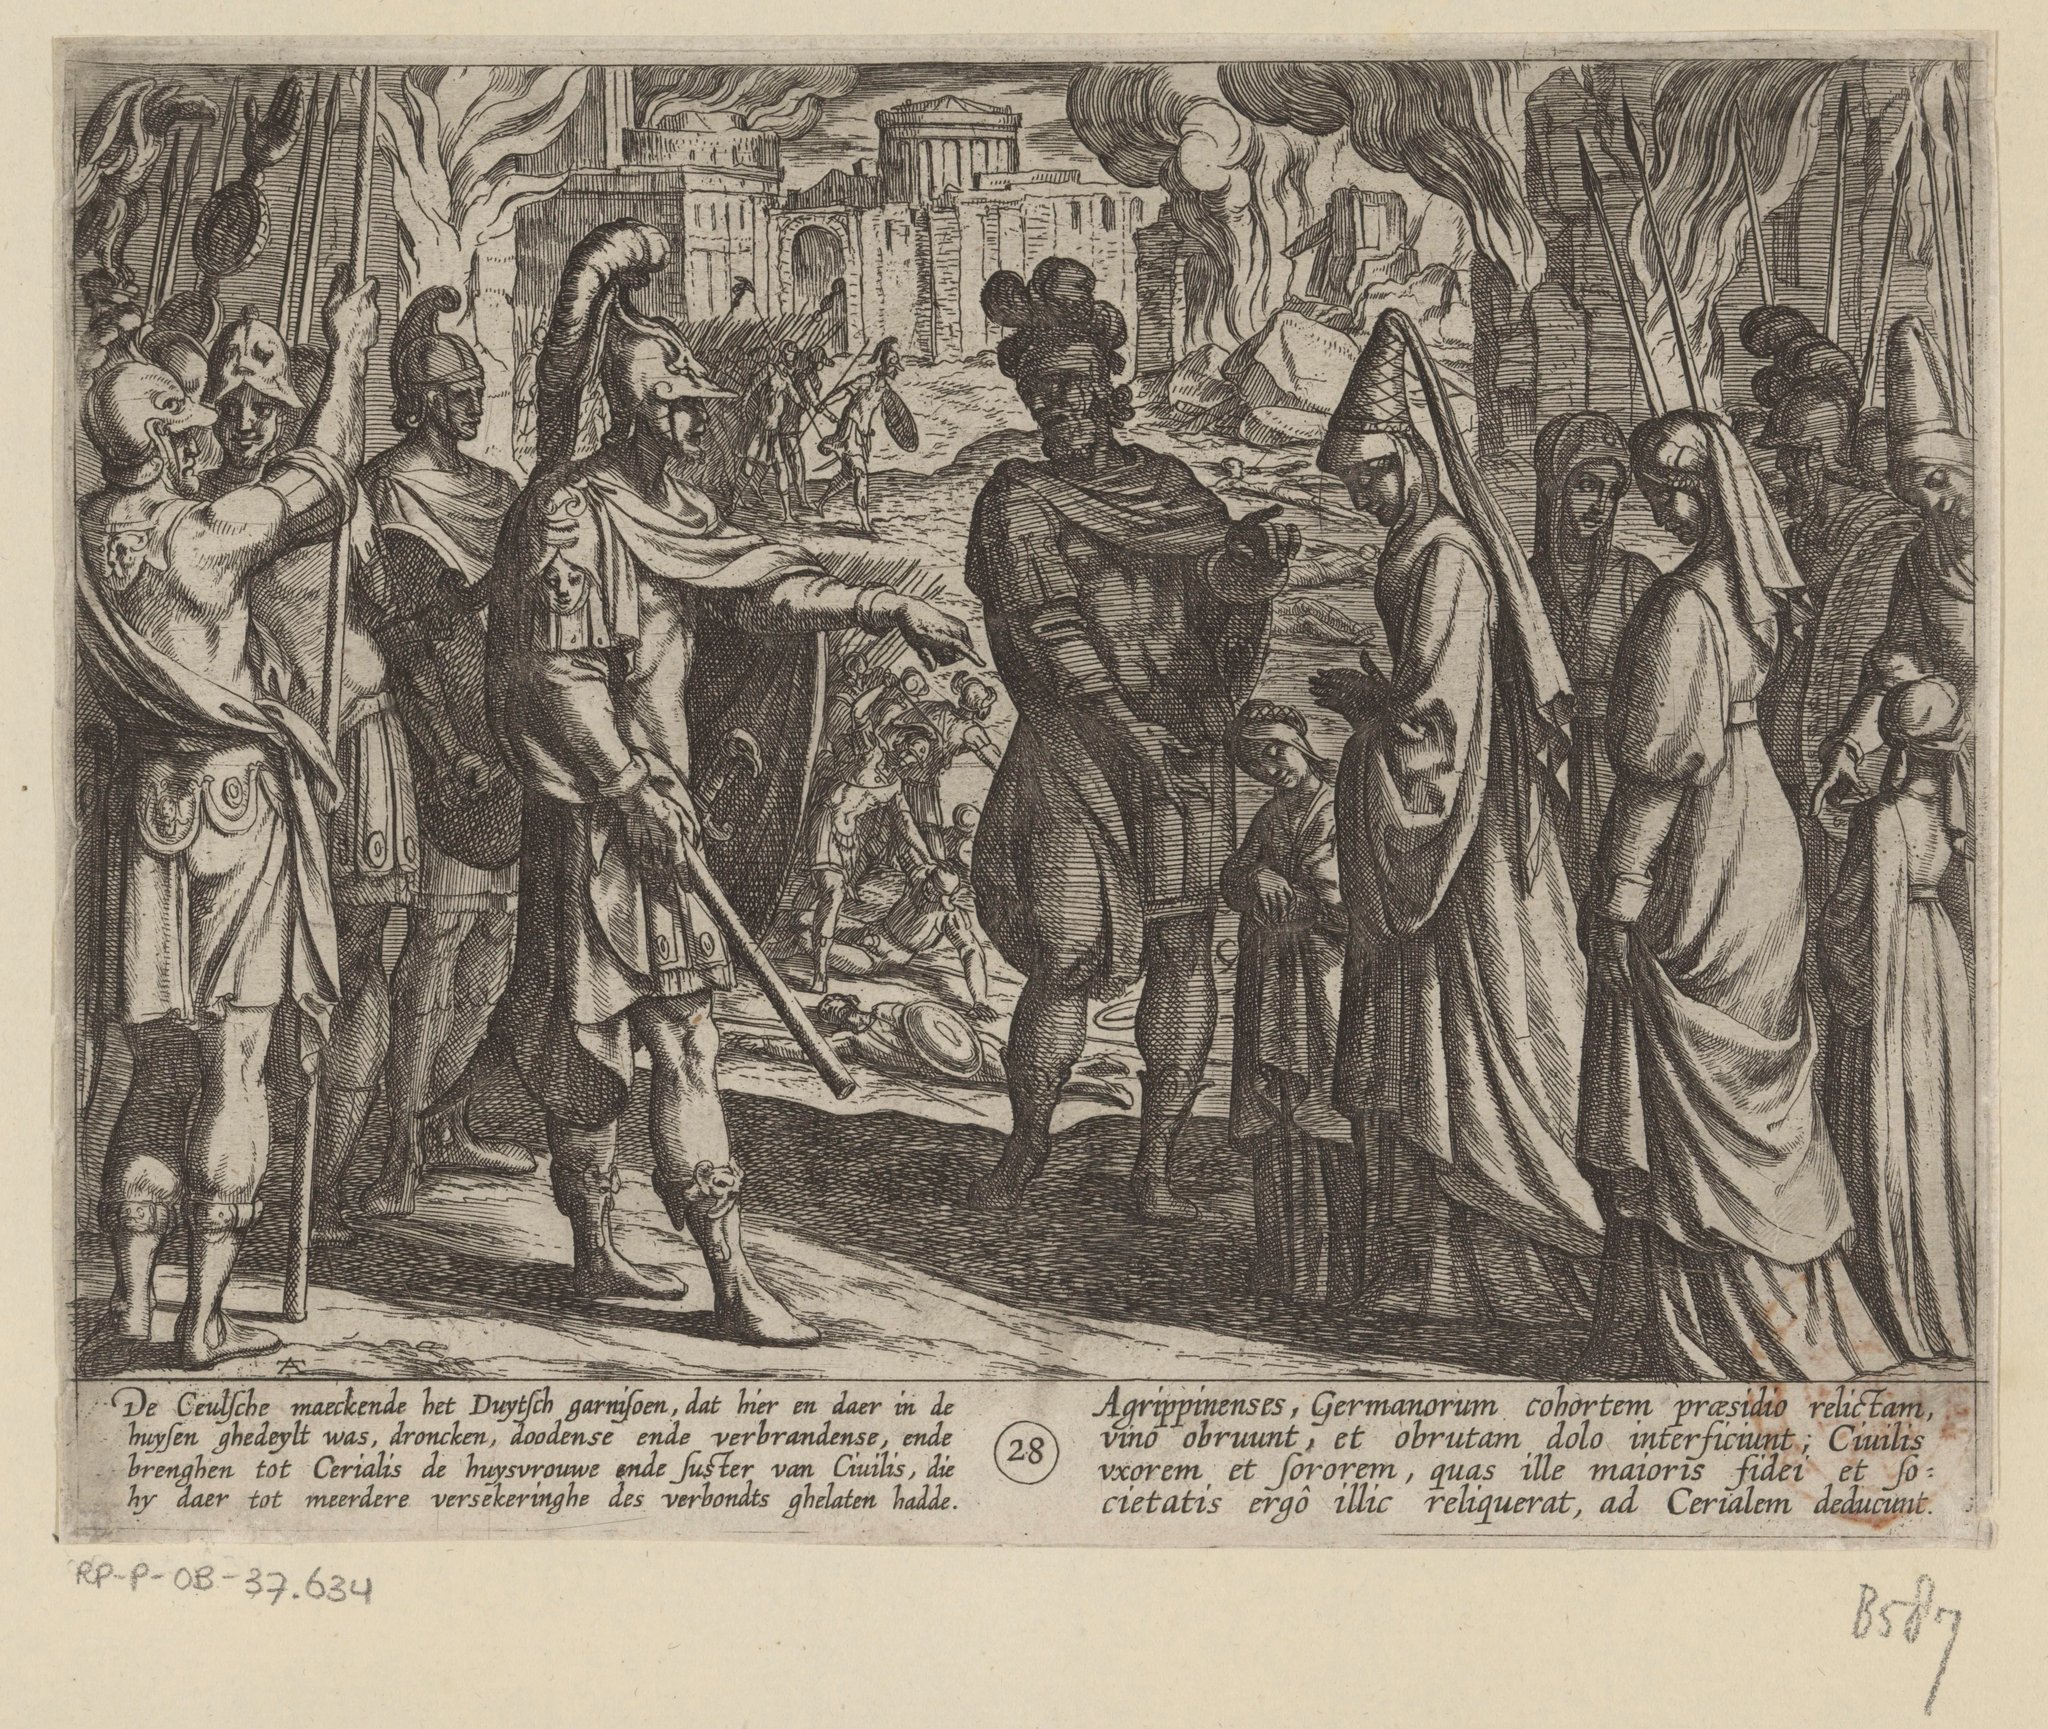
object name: print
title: De Bataafse oorlogen tegen de Romeinen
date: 1611-1612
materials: paper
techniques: etching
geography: italy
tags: ransom ~ prisoner of war, the soldier; the soldier's life, (story of) julius claudius civilis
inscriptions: collector's mark: Lugt 240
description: Deze prent maakt deel uit van een reeks van 36 prenten (+ titelpagina) over de oorlogen tussen de Romeinen en de Bataven.